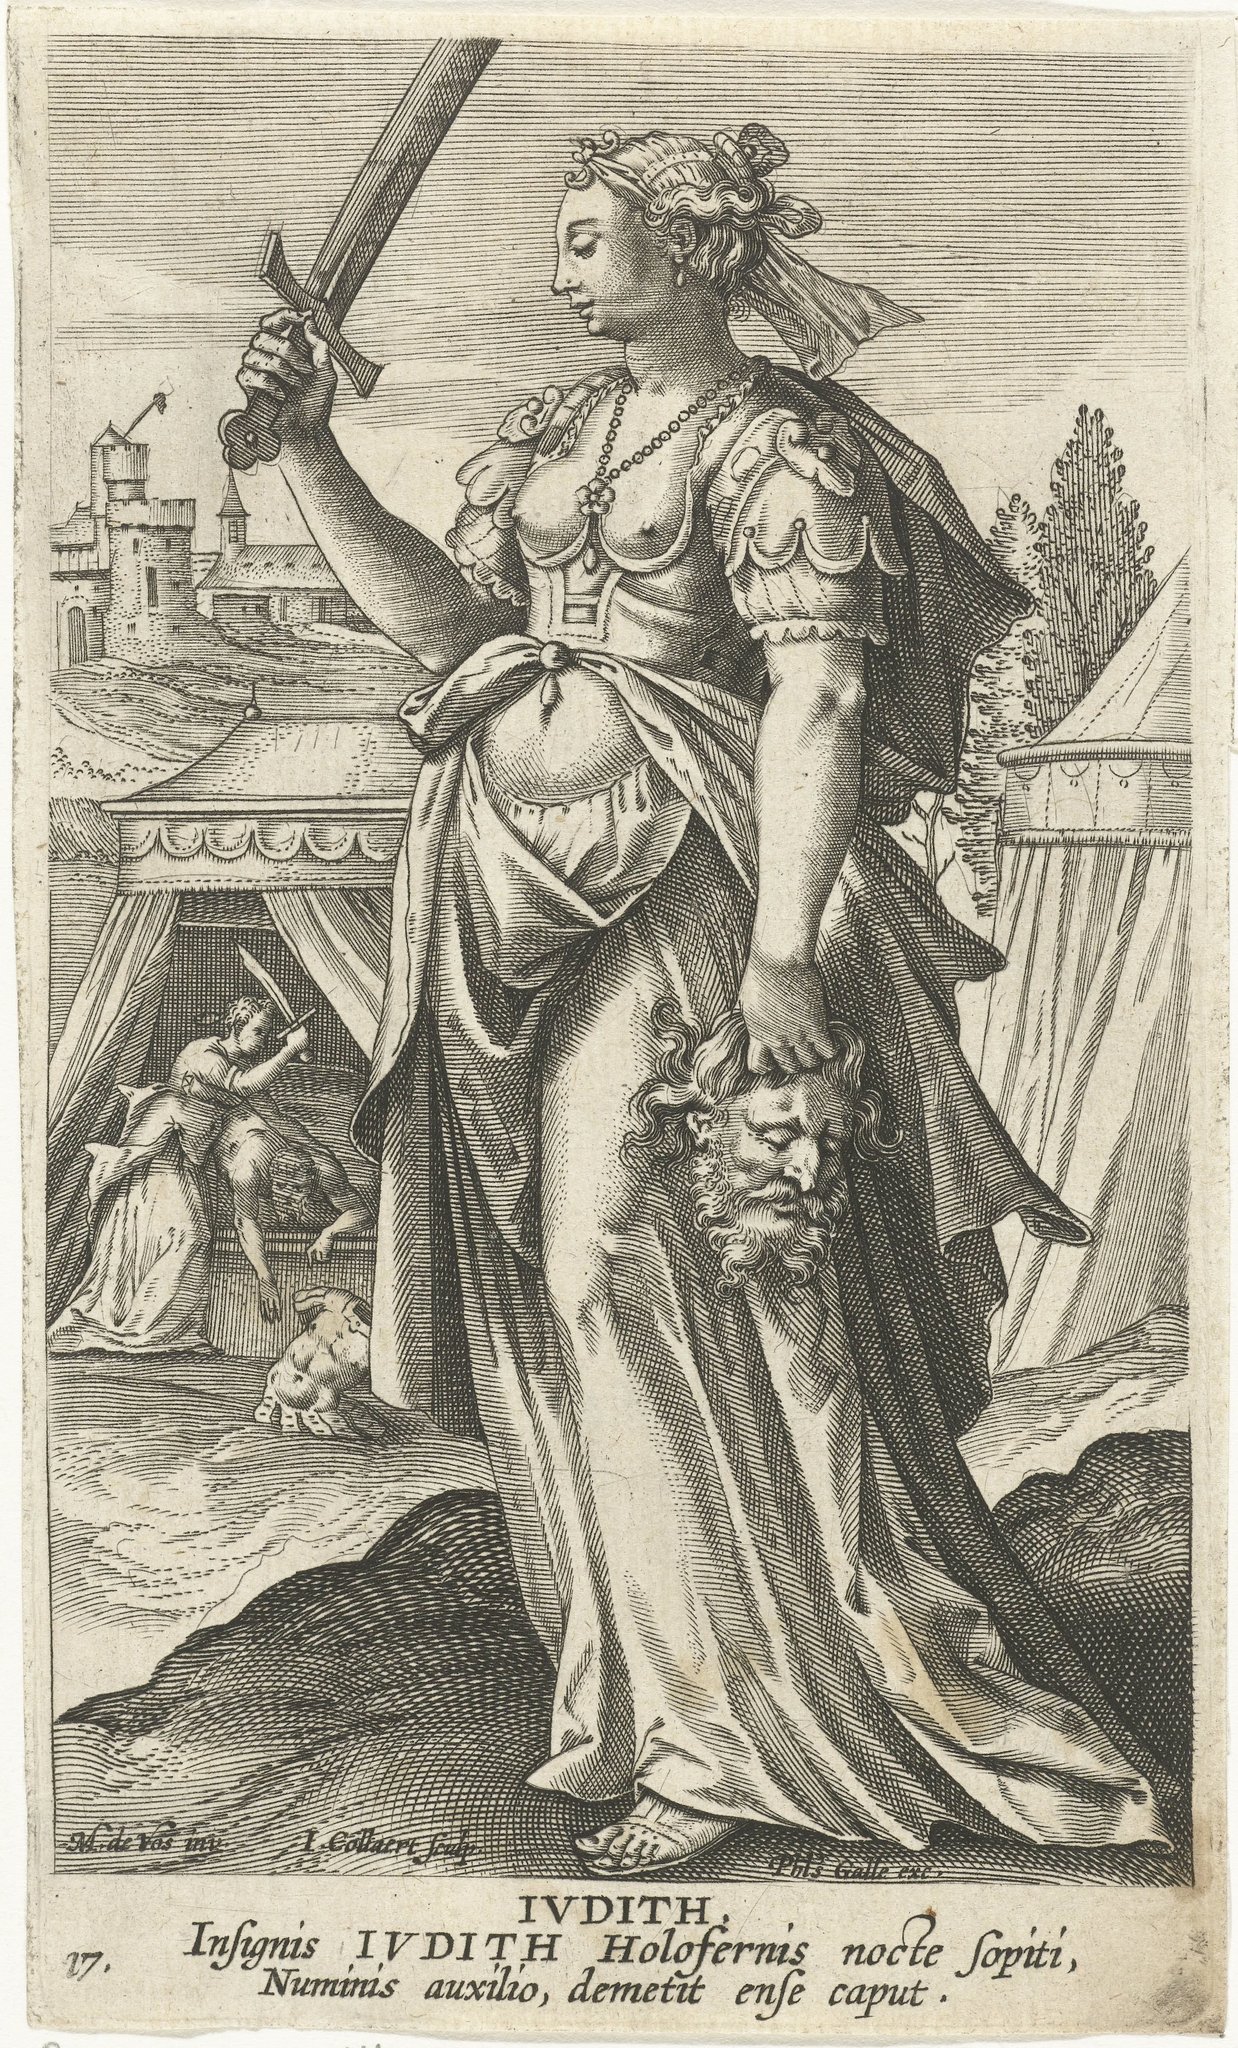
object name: print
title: Judit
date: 1588-1597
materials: paper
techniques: engraving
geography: antwerp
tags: holofernes beheaded by judith with his own sword; the maidservant may be keeping watch, female persons from the old testament (with name) (not in biblical context)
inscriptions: collector's mark: Lugt 2228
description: Op de voorgrond Judit, een zwaard in haar ene hand en het hoofd van Holofernes in de andere. Op de achtergrond de tent van Holofernes, waar Judit het hoofd van de generaal afslaat. De prent heeft een Latijns onderschrift en maakt deel uit van een prentserie met beroemde vrouwen uit het Oude Testament.